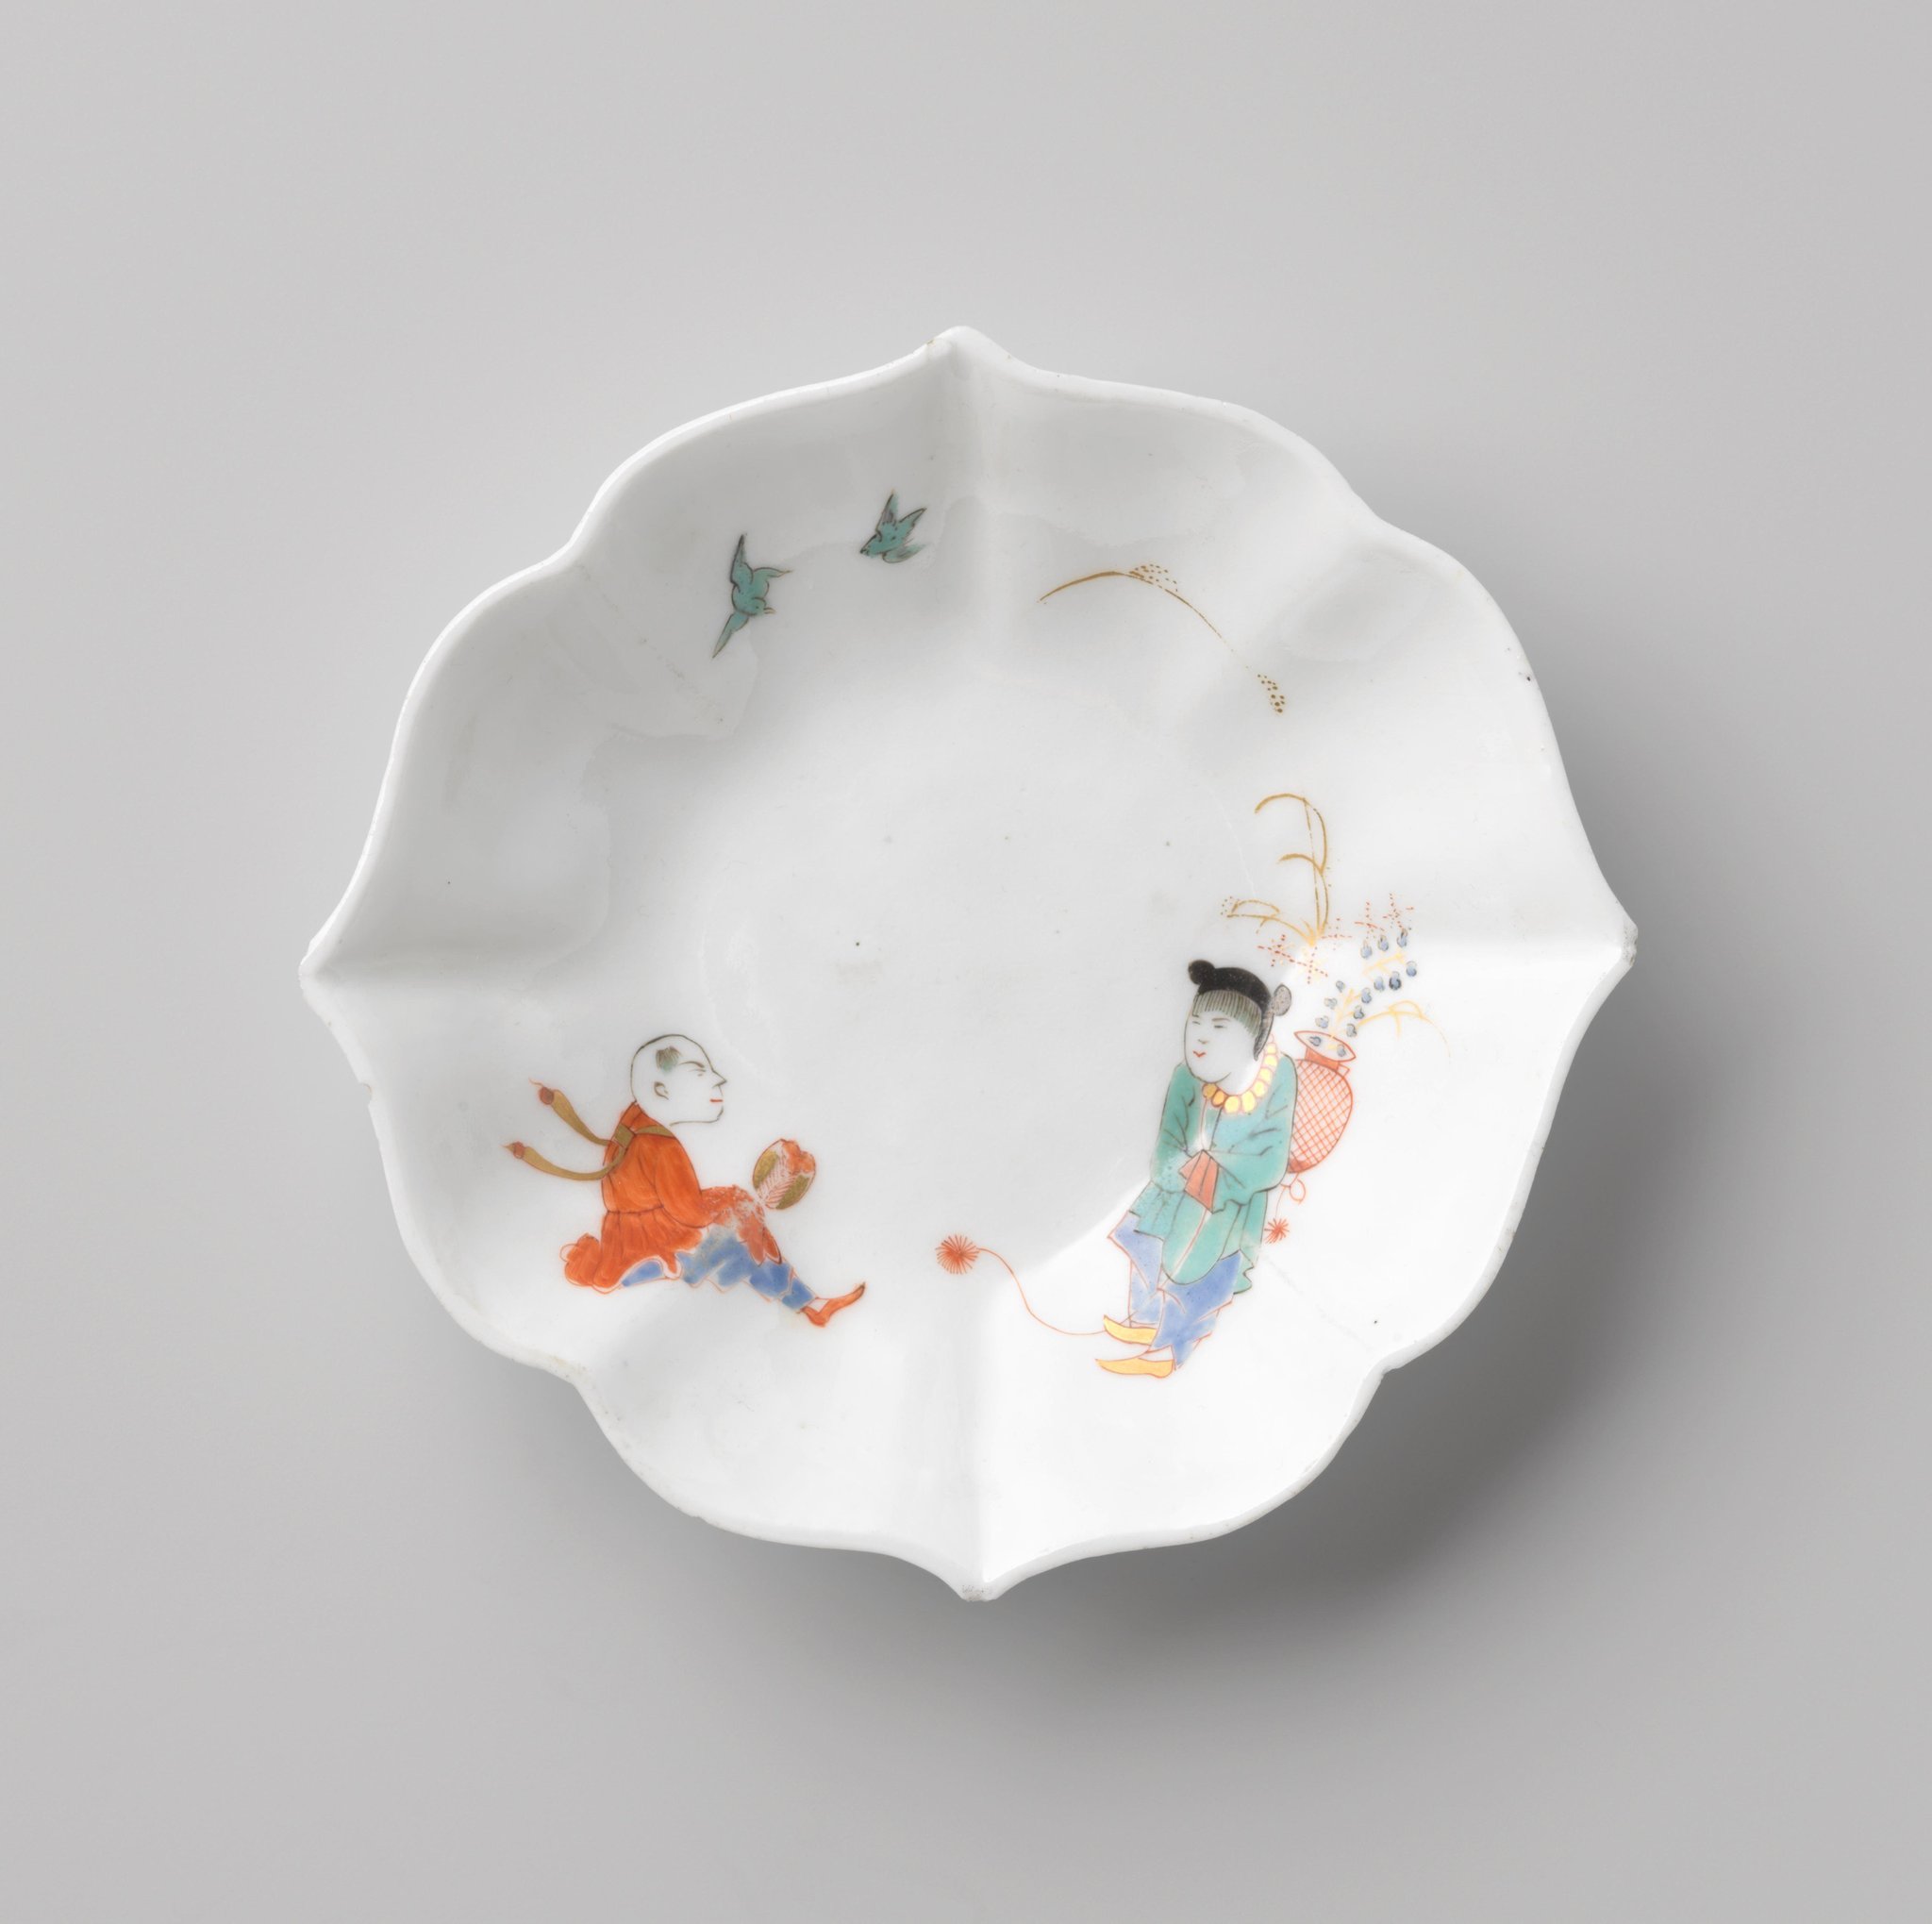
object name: eating drinking utensil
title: Schotel, veelkleurig beschilderd met een Kakiemon-decor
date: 1730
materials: porcelain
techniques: painted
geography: meissen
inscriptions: number: ‘85.’, factory mark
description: Cup and saucer. Porcelain. Meissen, c. 1730.